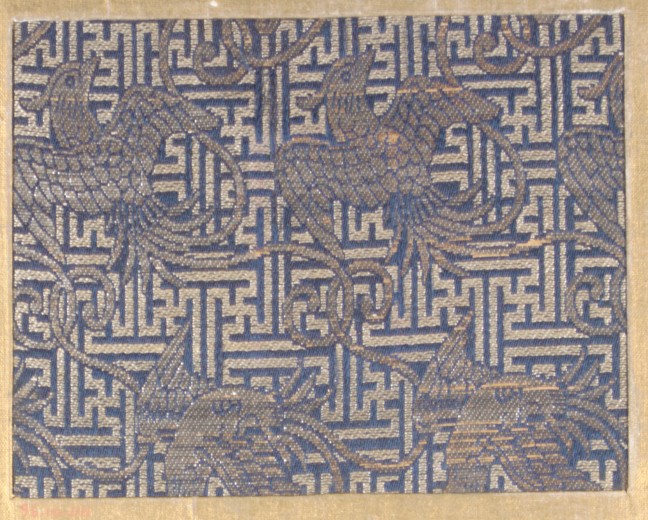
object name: piece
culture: japanese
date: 1701-1900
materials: silk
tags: birds